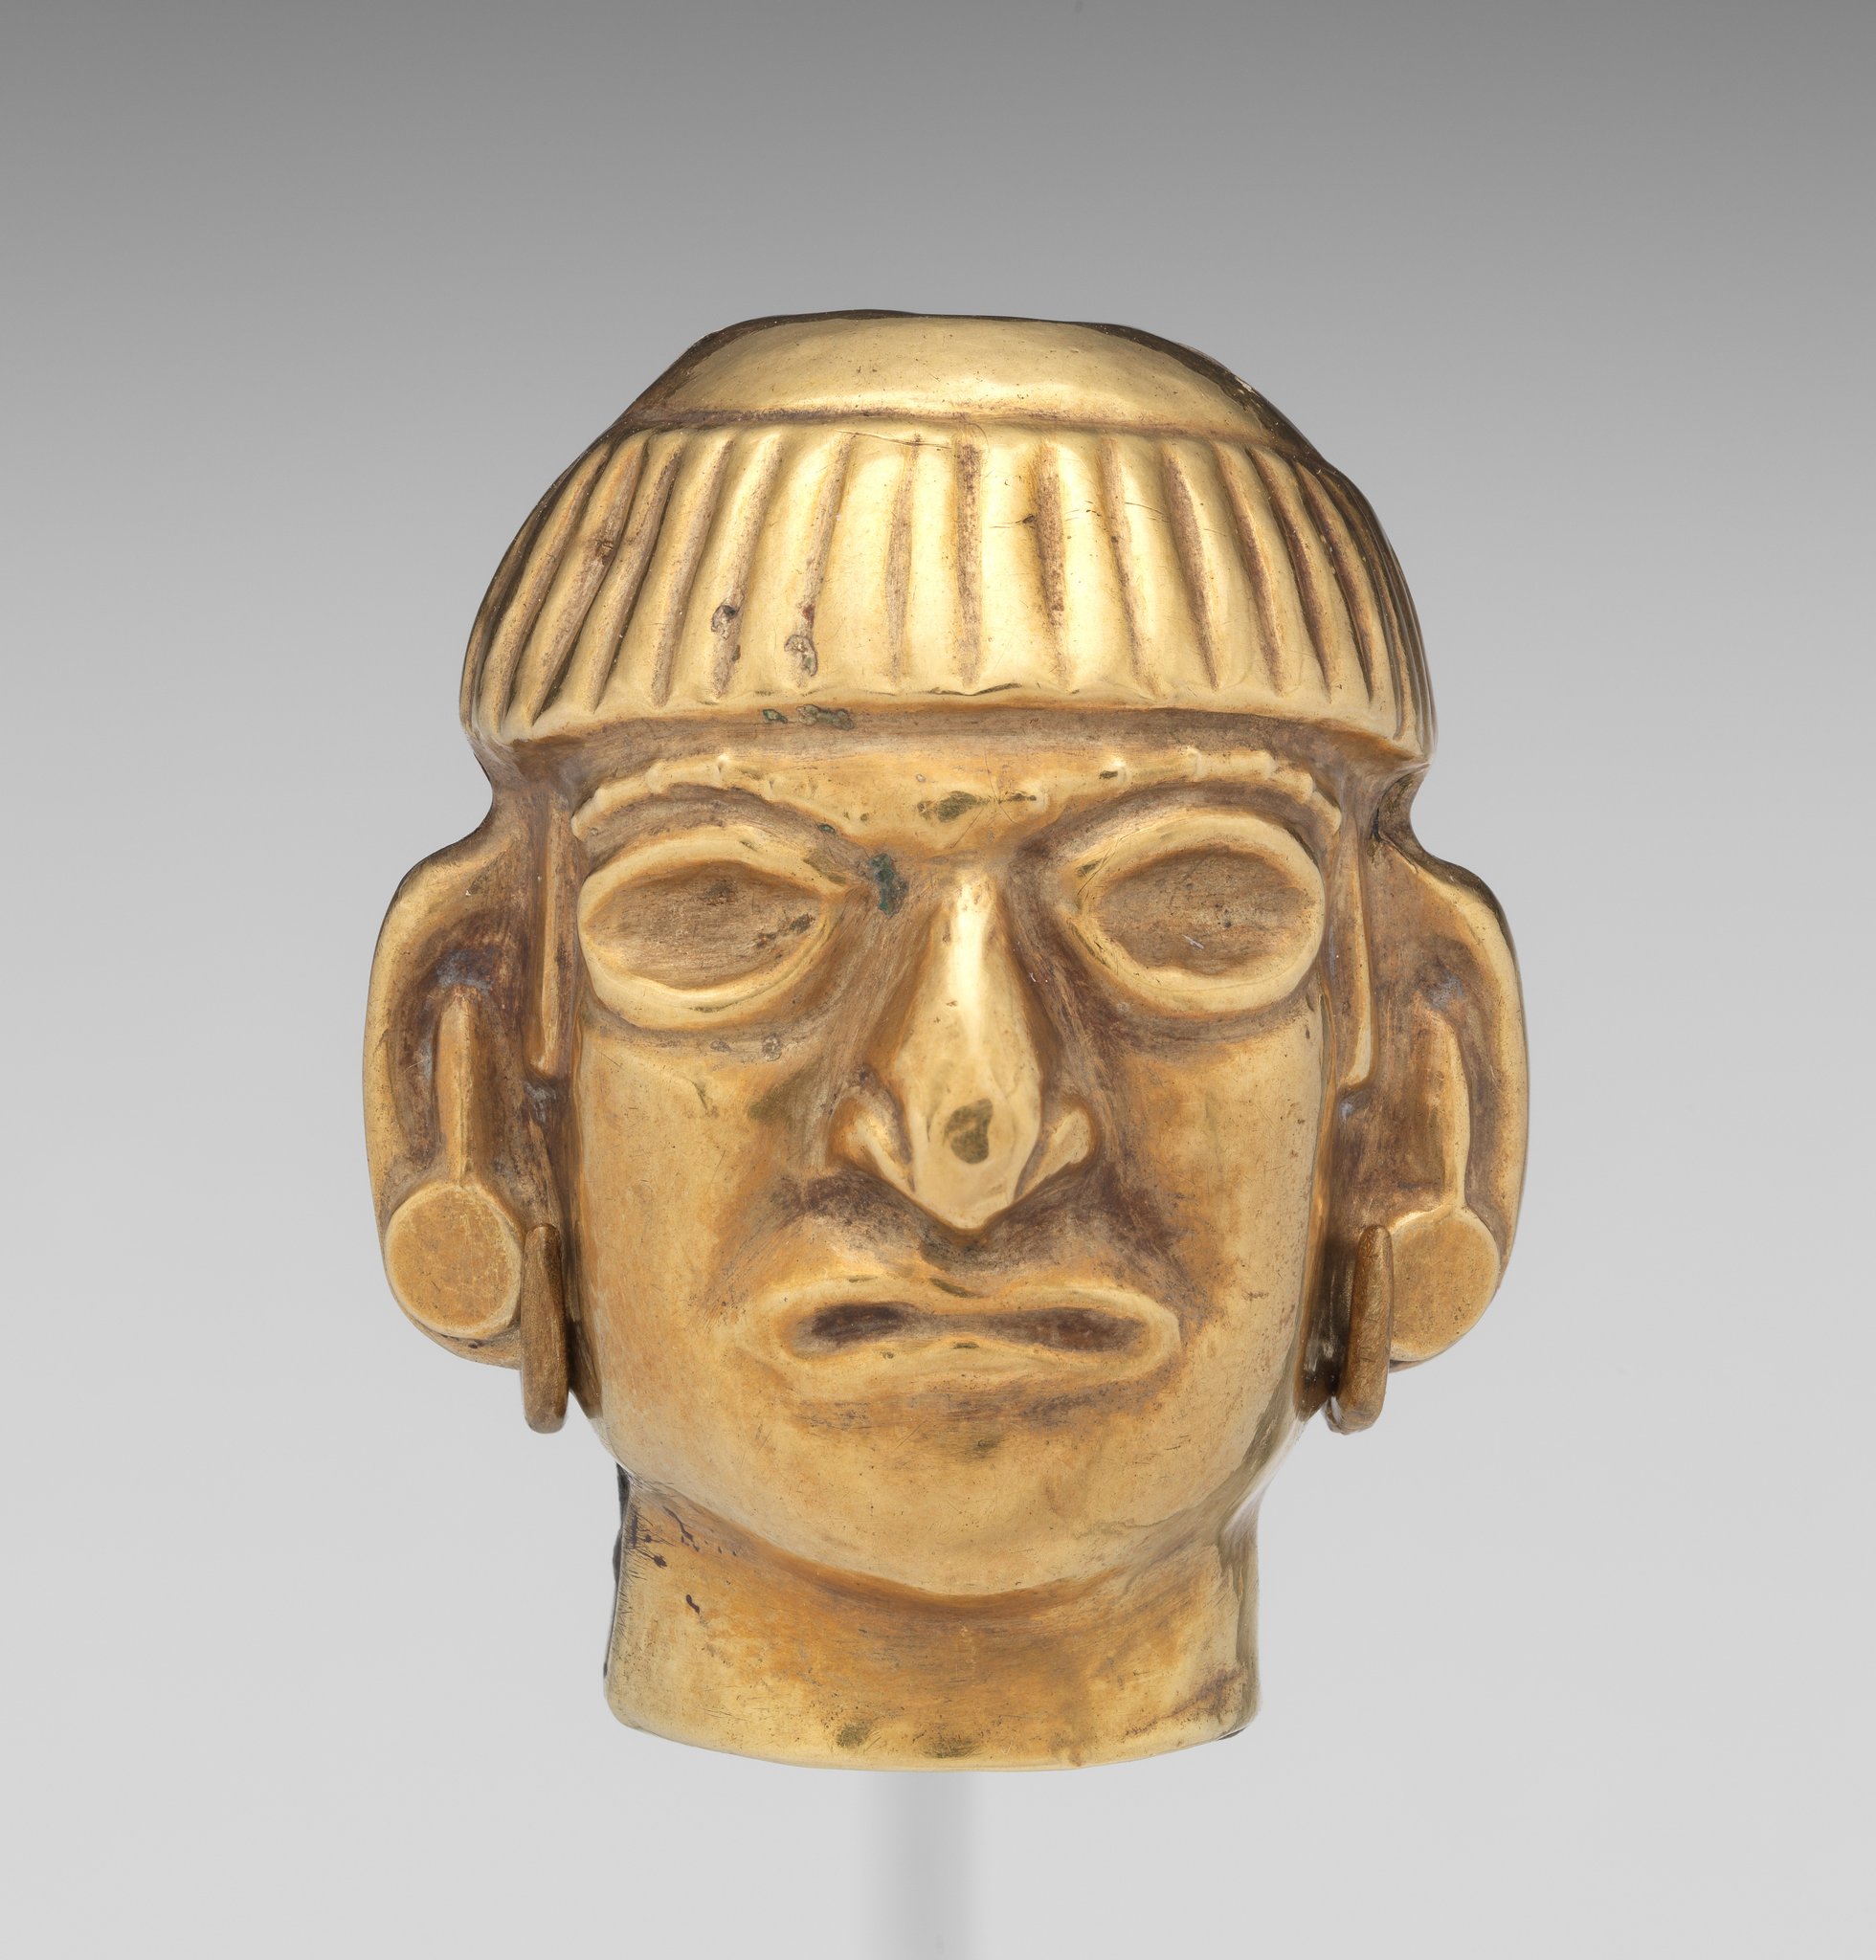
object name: bead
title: Head-shaped bead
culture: moche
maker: moche artist(s)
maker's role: artist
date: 200-800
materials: gold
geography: peru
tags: heads